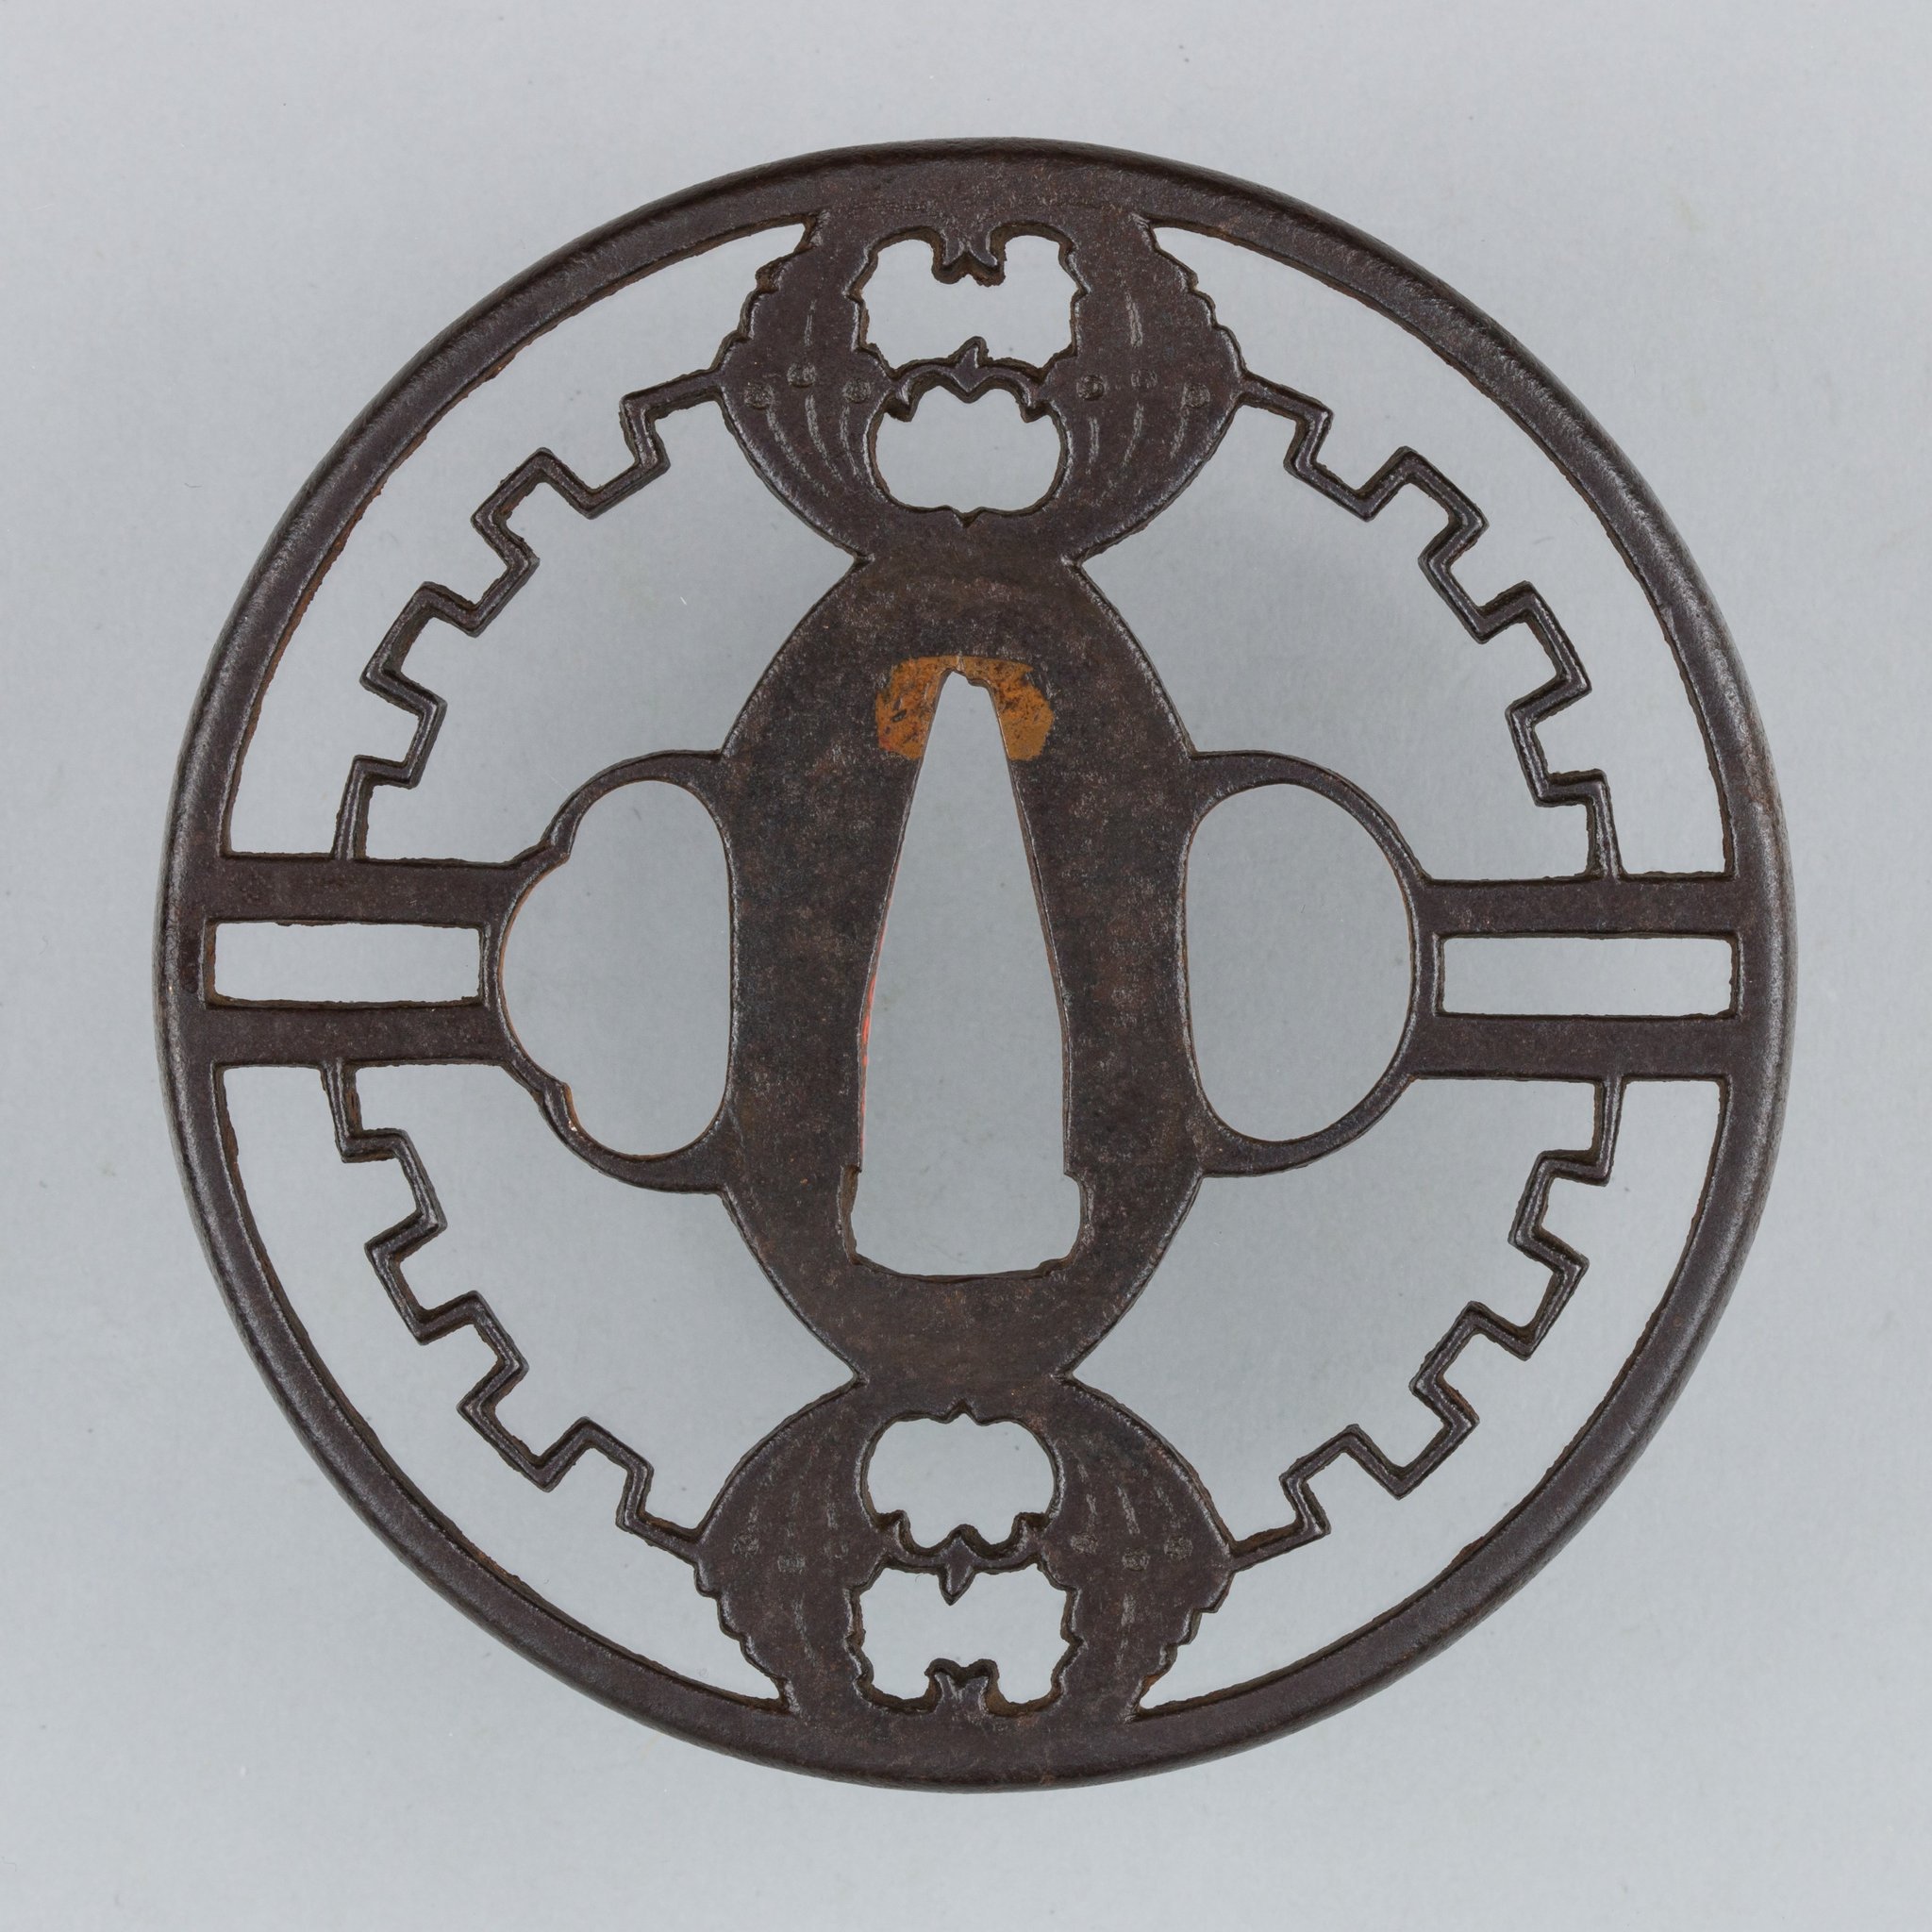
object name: sword guard tsuba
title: Sword Guard (Tsuba)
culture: japanese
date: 1567-1633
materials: copper, iron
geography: japan